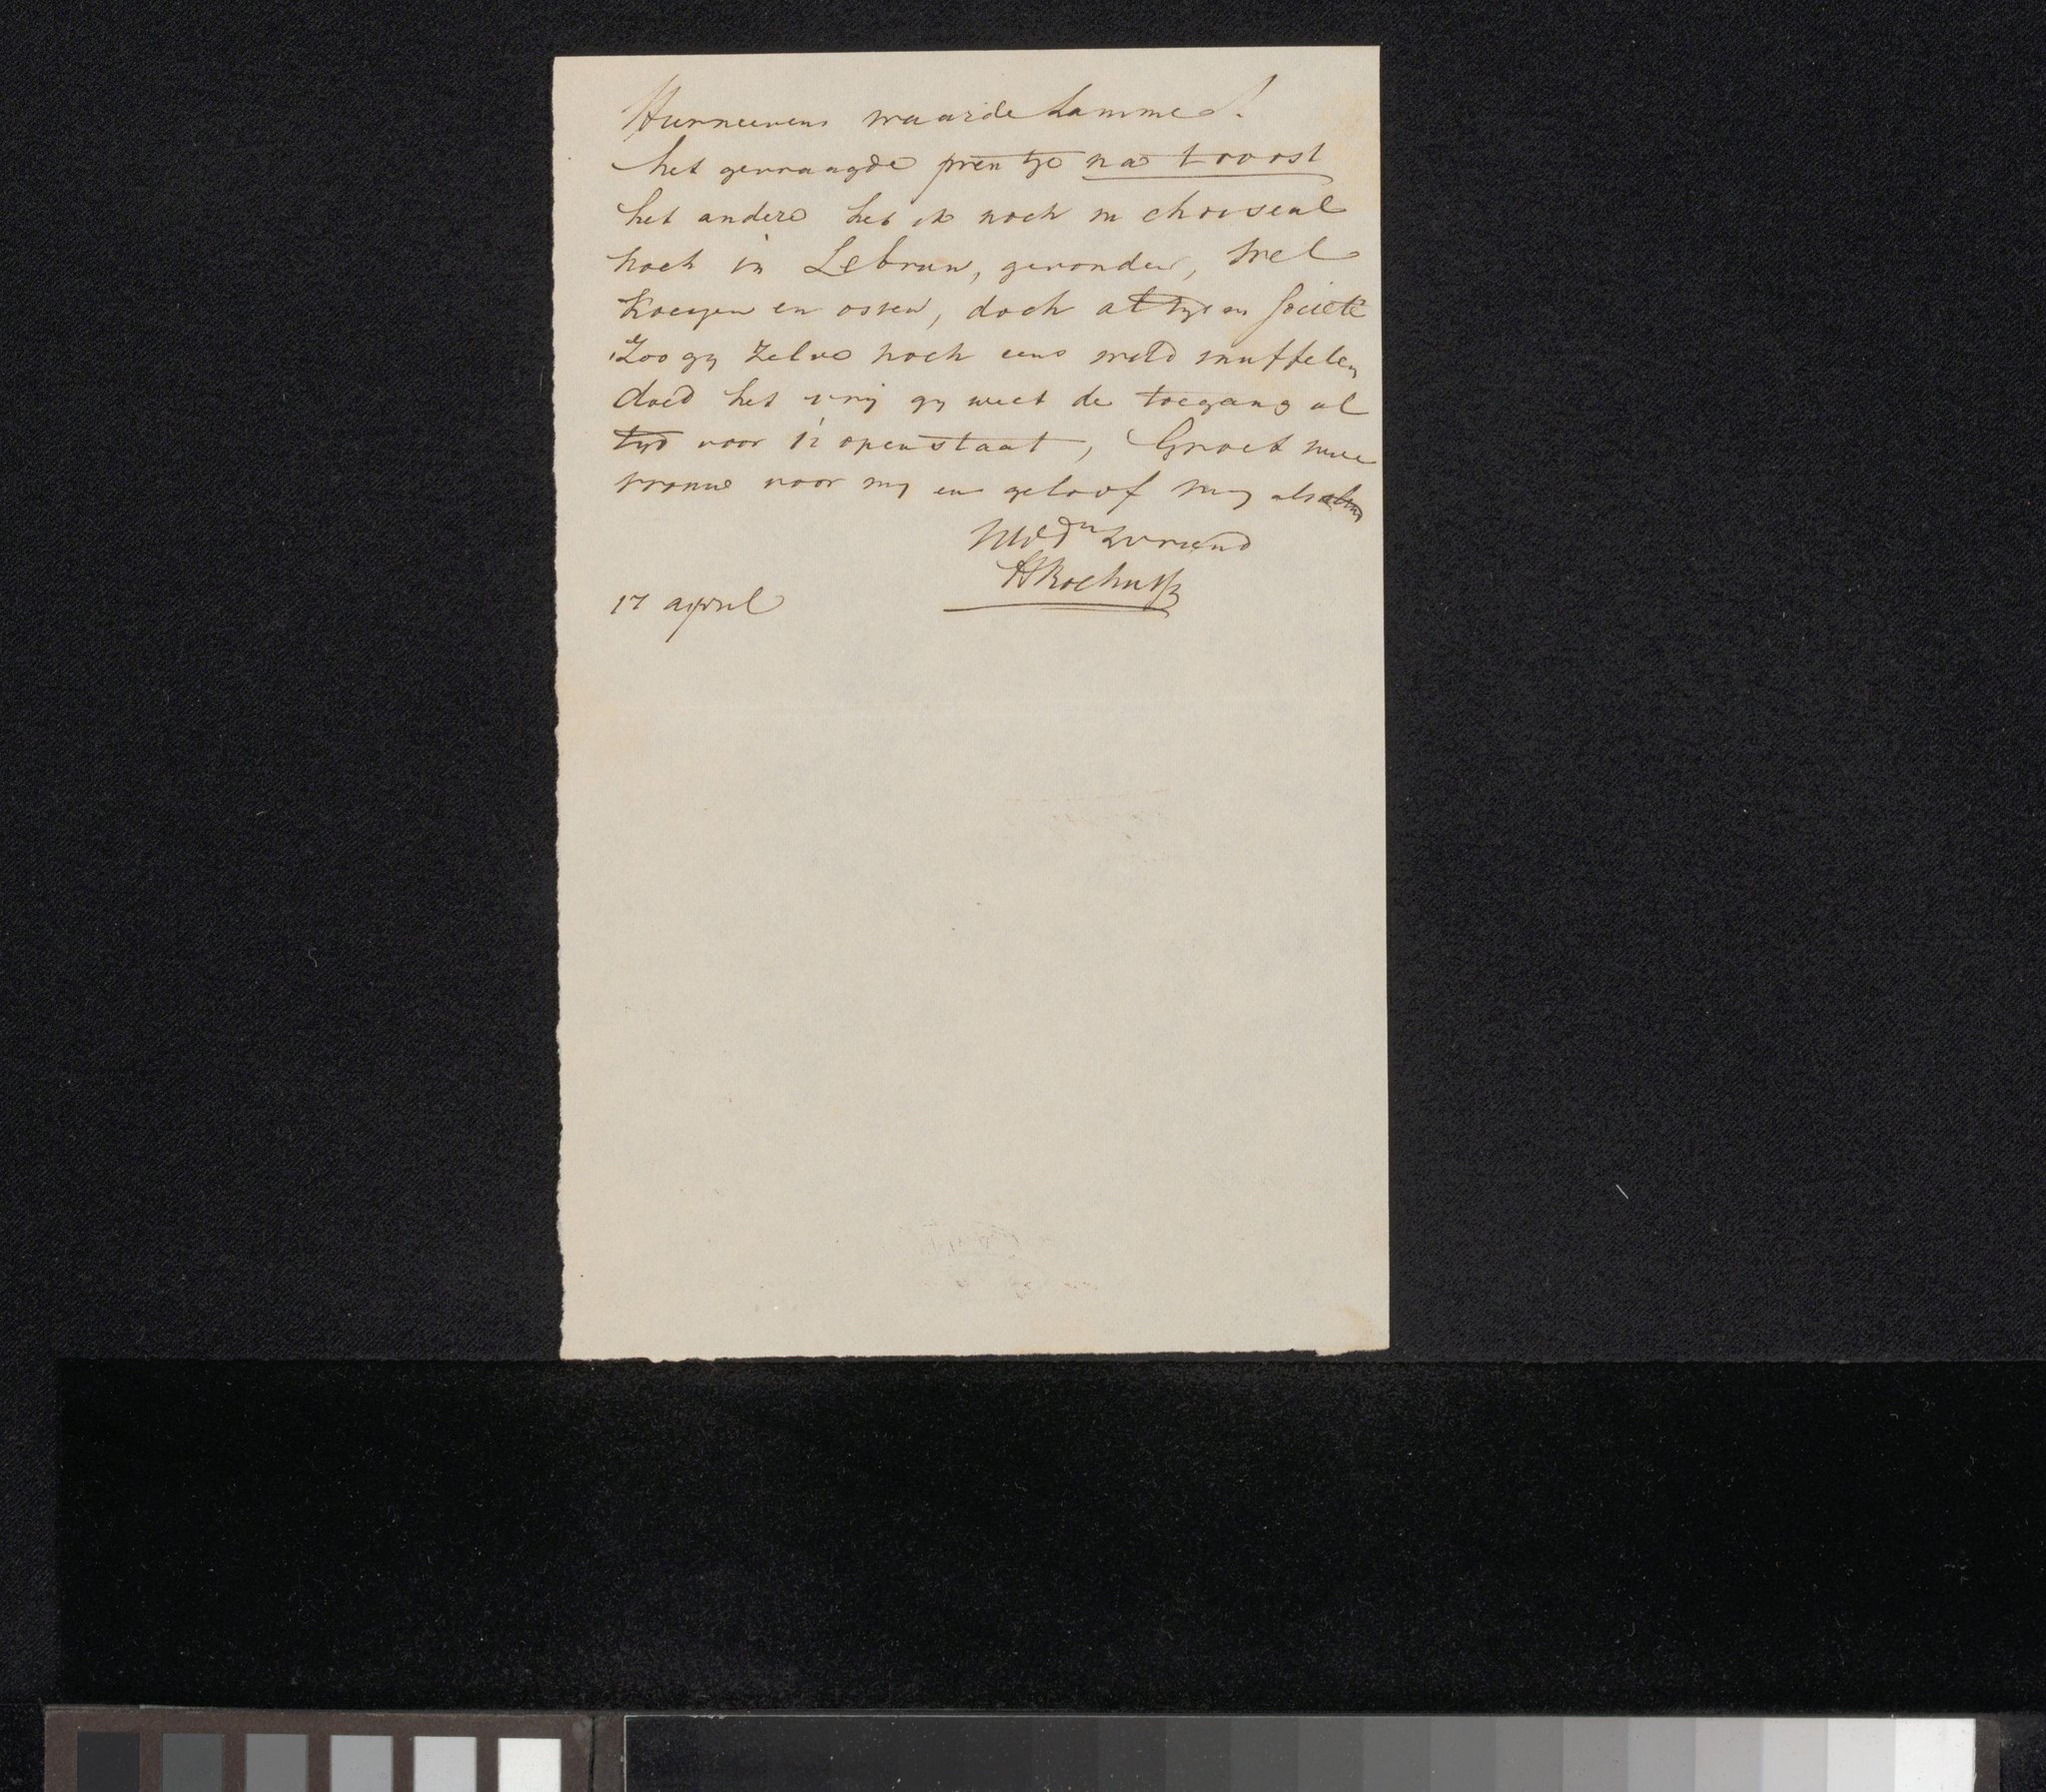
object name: letter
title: Brief aan Ary Johannes Lamme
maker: hendrik rochussen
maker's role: print maker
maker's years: 1779-1852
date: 1822-1852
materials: ink, paper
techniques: pen, writing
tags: painter, draughtsman, cornelis troost, ary johannes lamme, the graphic arts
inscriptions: collector's mark: Lugt 2228